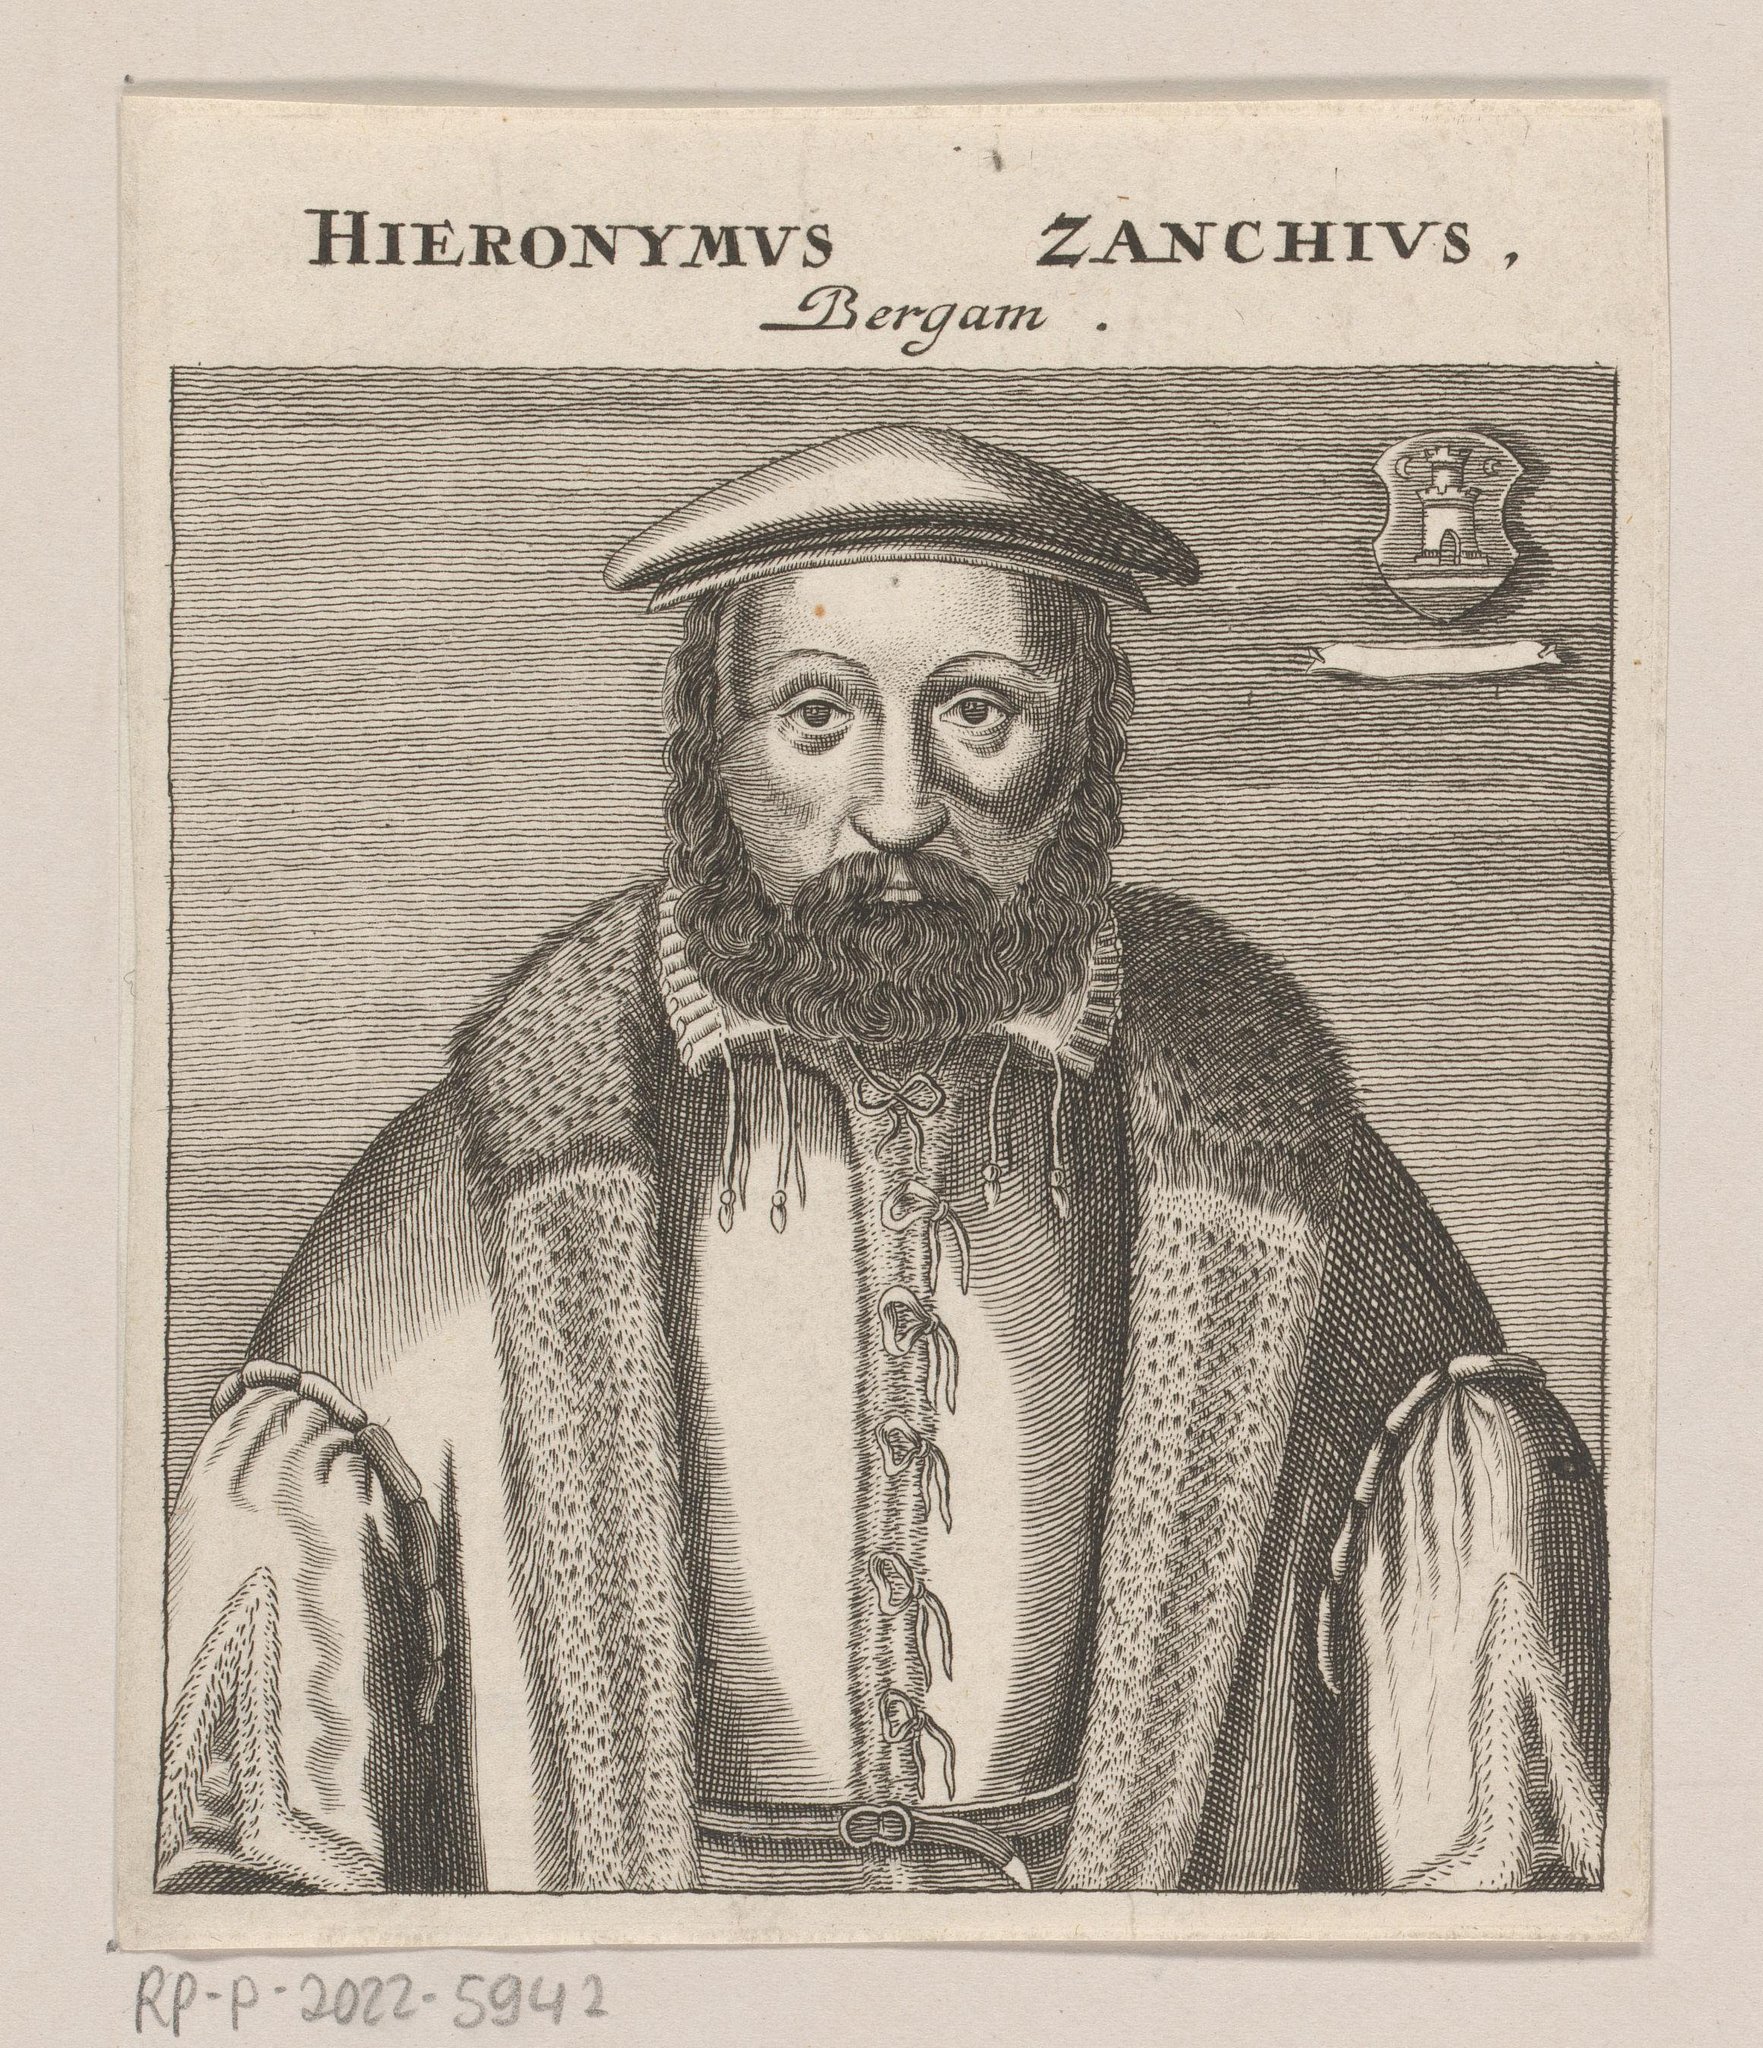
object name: print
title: Portret van Hieronymus Zanchius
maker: Anonymous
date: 1604-1650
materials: paper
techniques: engraving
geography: the hague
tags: reformation (roman catholic church vs. protestantism), theologian, historical persons